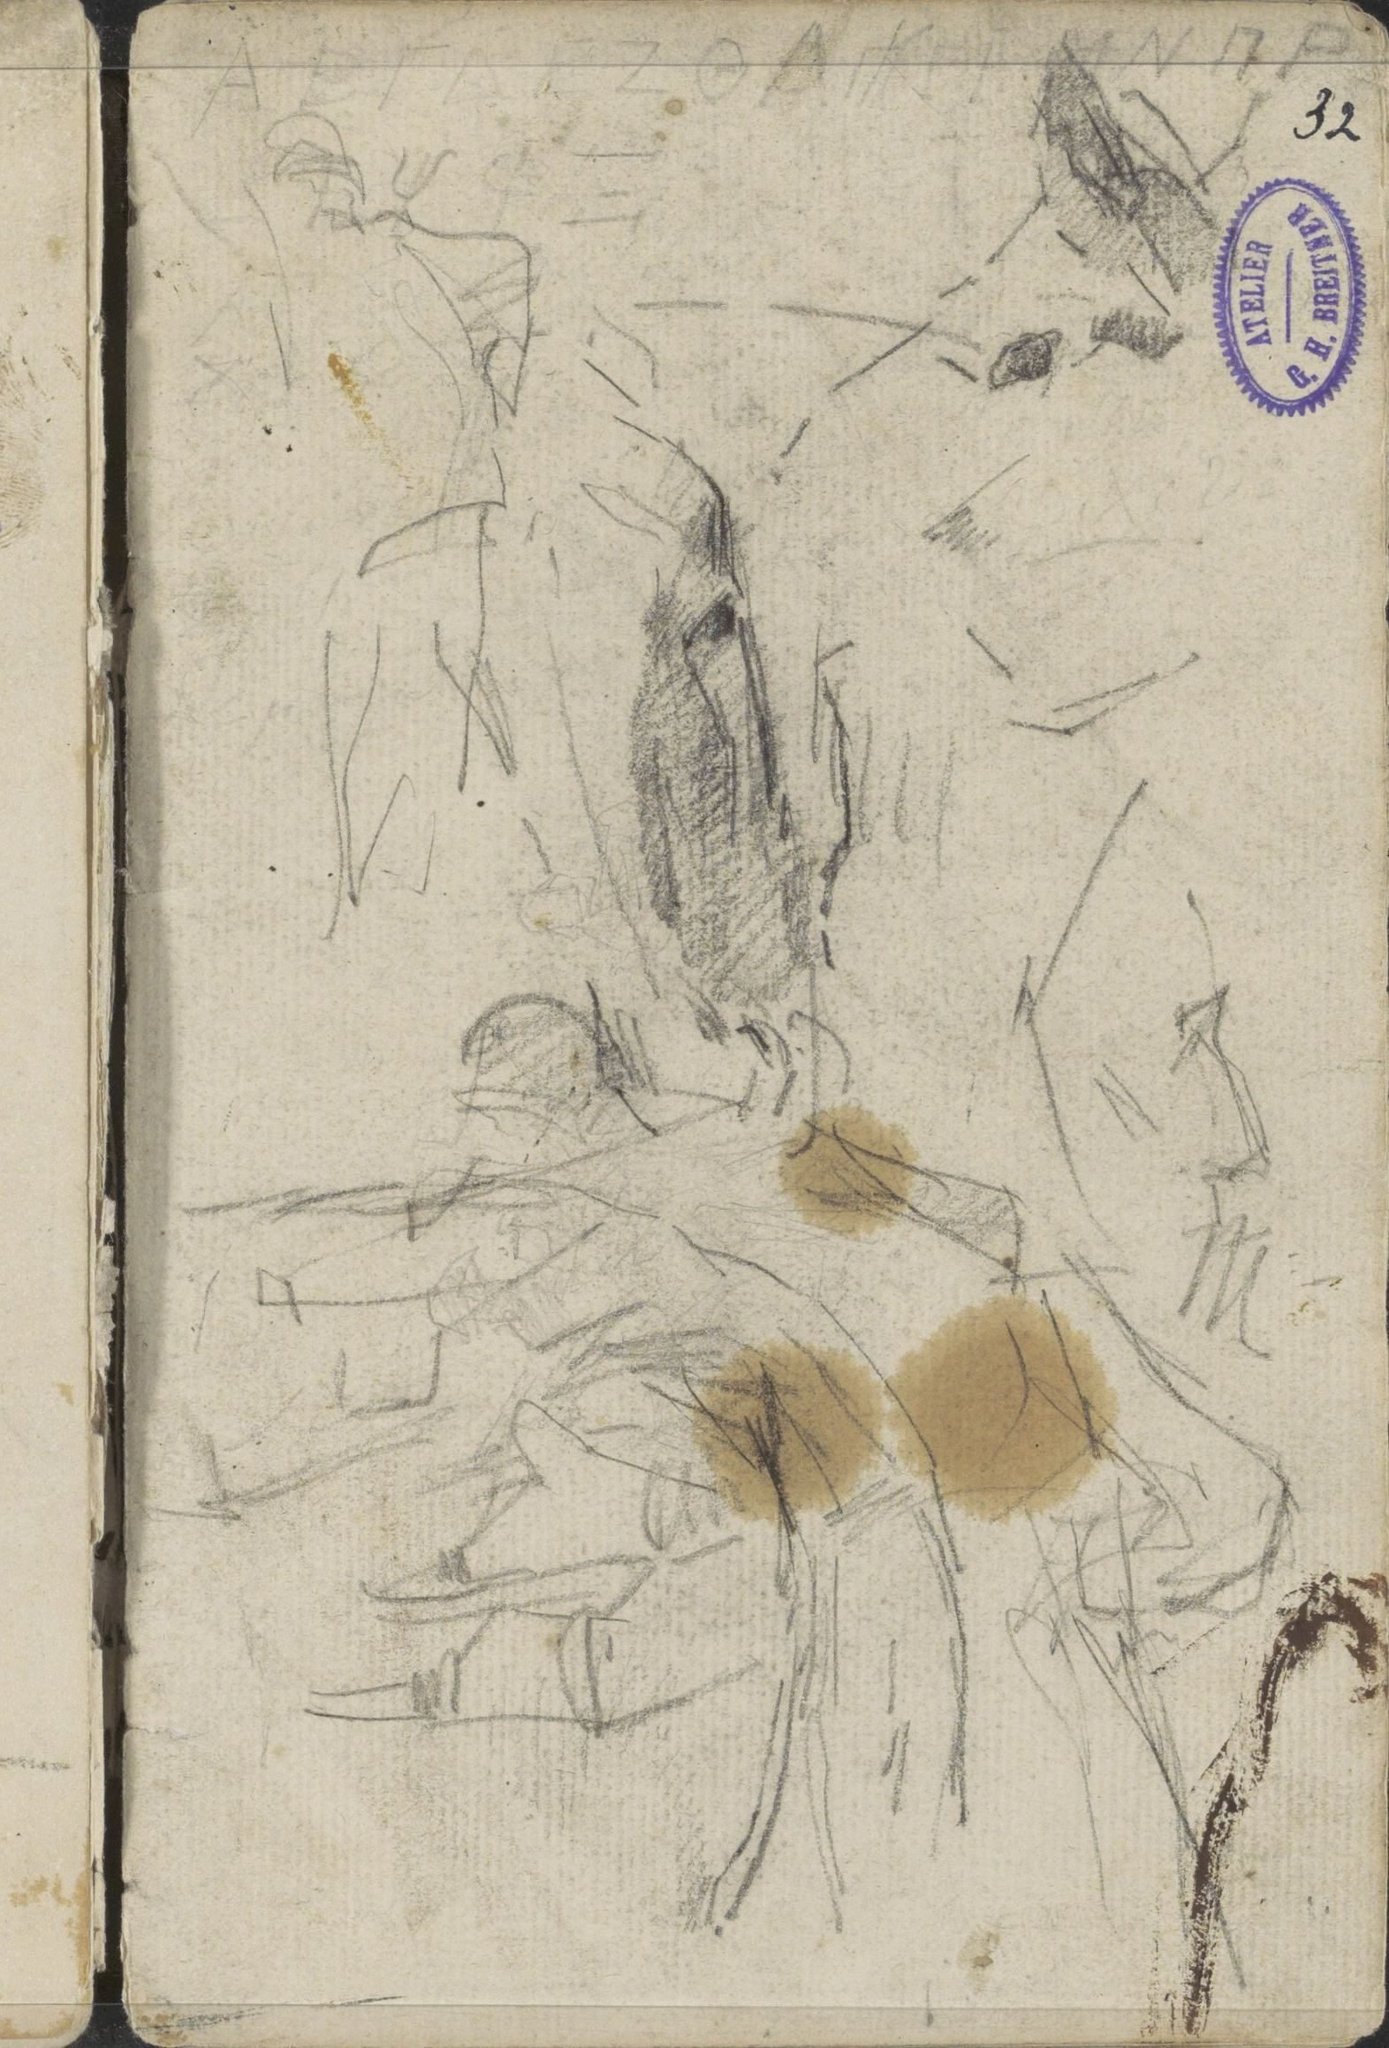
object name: sketchbook leaf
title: Figuurstudies en paardenhoofden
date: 1880-1882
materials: chalk, paper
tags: head (human), canals, waters (in city), horse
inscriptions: workshop stamp: Lugt 291d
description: Blad 32 recto uit een schetsboek met 16 bladen.